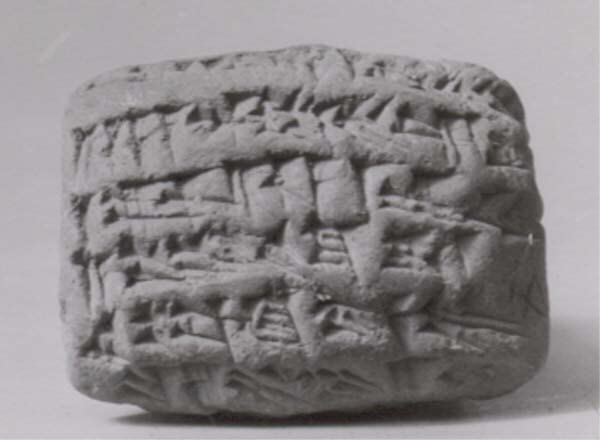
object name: cuneiform tablet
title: Cuneiform tablet impressed with scaraboid (?) ring seal: receipt for gold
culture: babylonian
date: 560 BCE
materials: clay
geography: mesopotamia